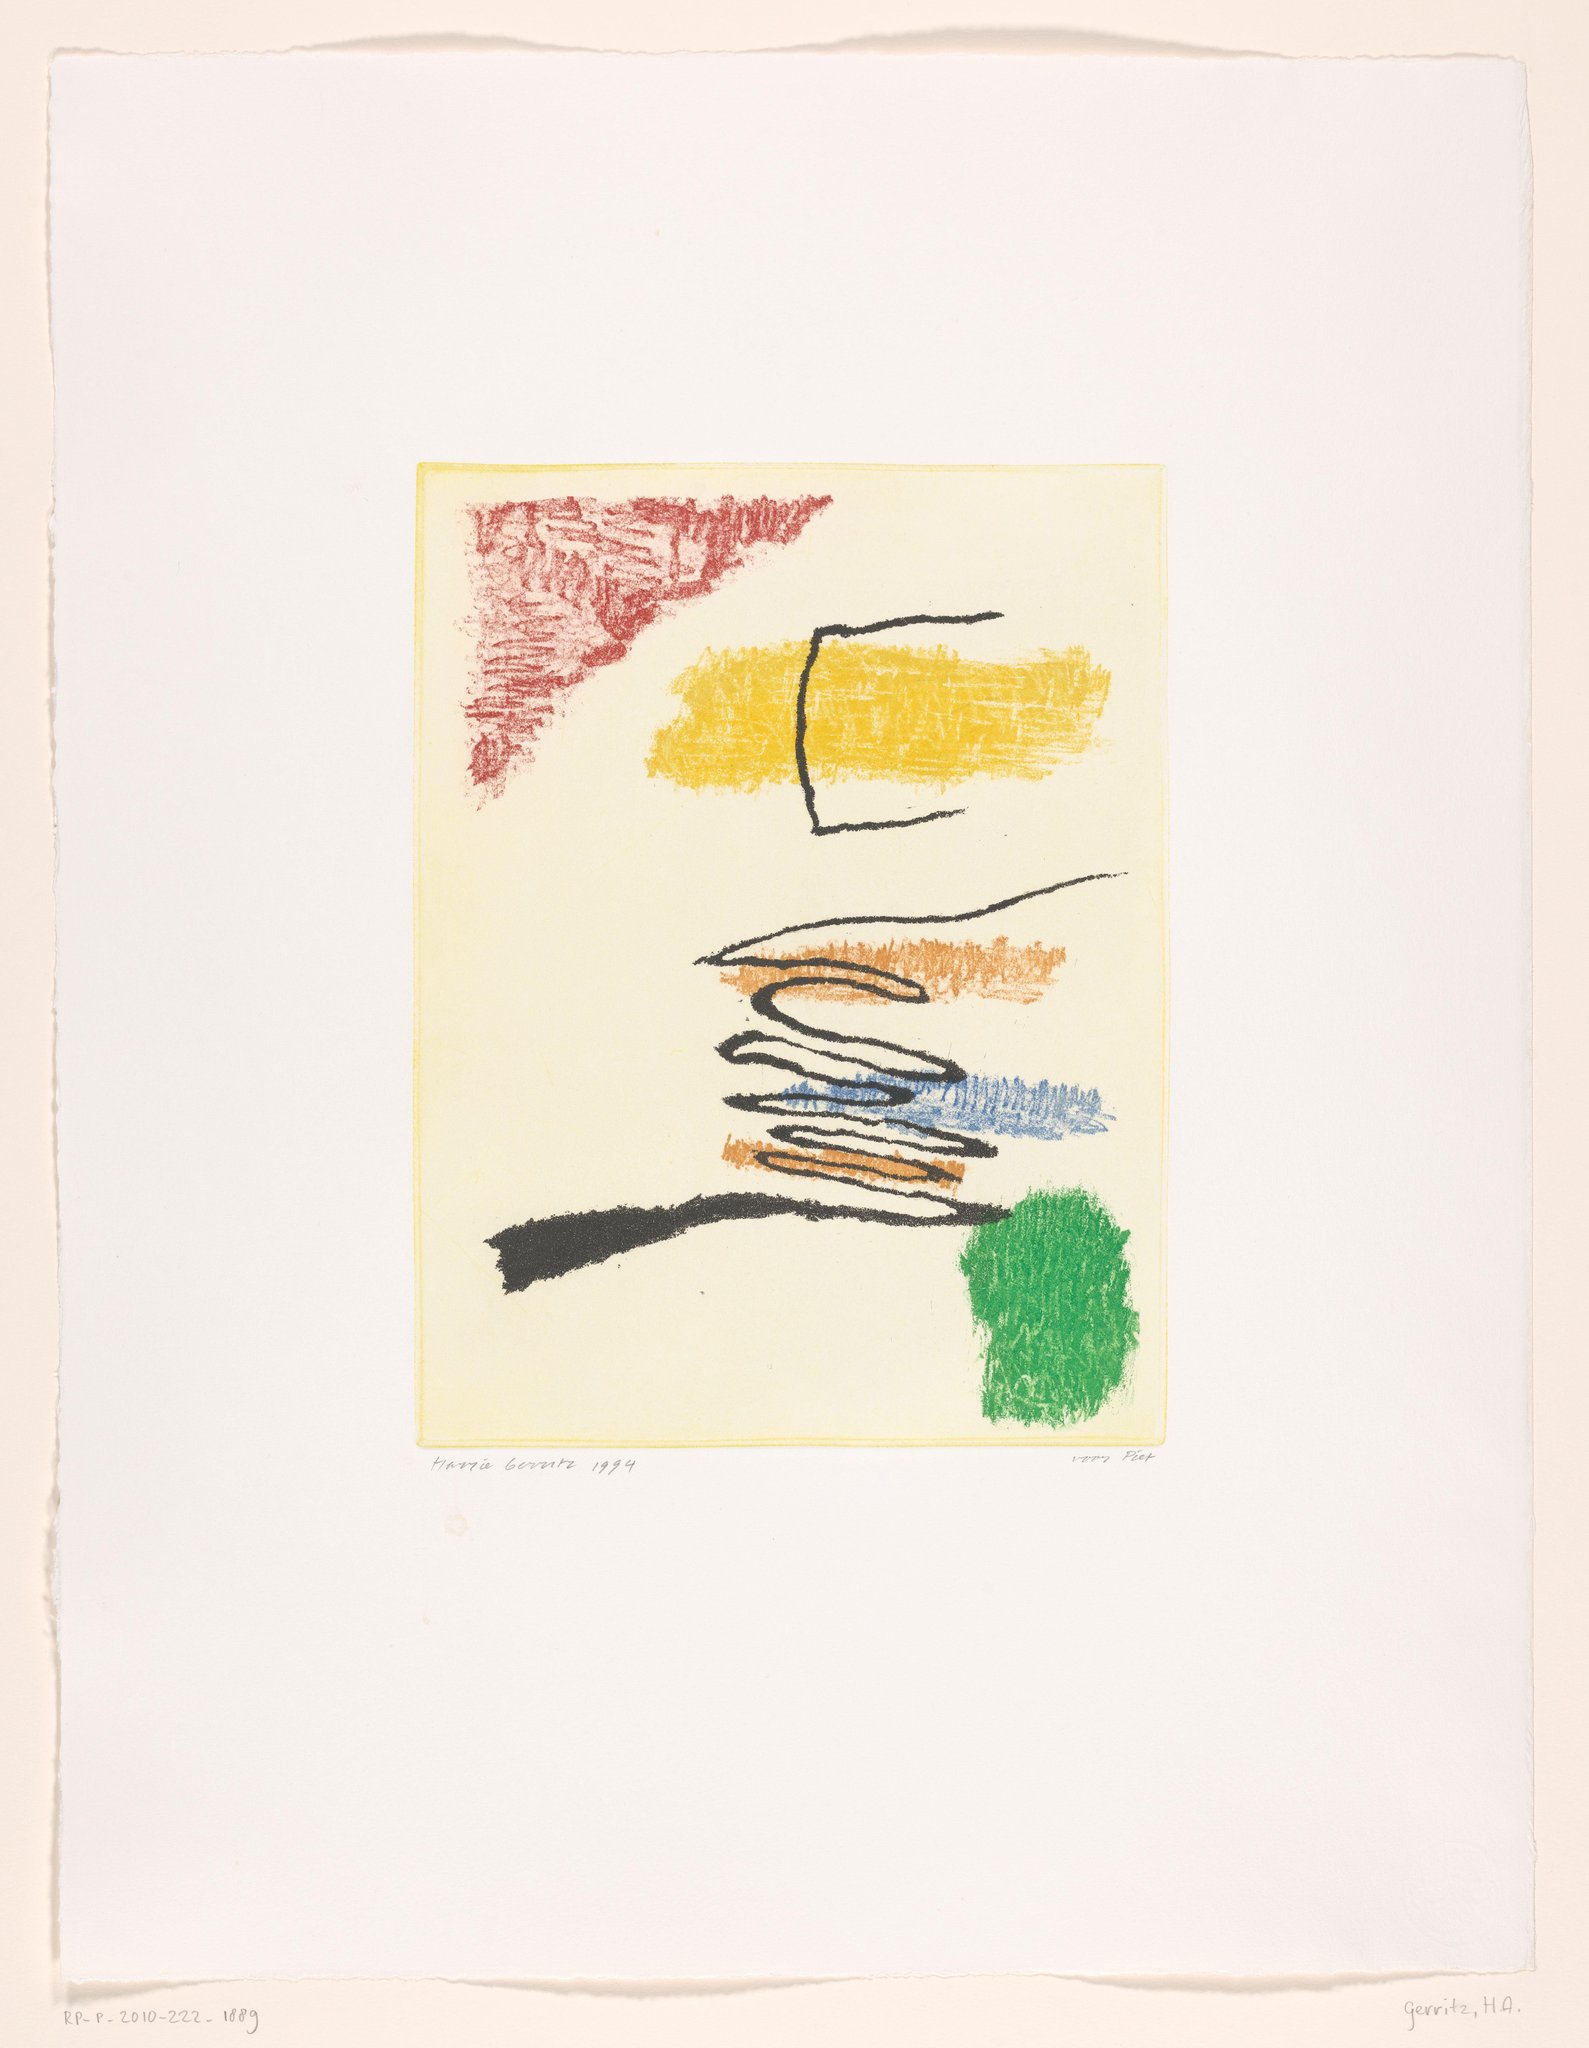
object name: print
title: Abstracte compositie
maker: harrie a. gerritz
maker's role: draughtsman, painter, print maker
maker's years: 1940-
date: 1994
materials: paper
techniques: aquatint, intaglio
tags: abstract, non-representational art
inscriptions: inscription: ‘PC’, collector's mark: Lugt 2228, watermark:, dedication: ‘voor Piet’